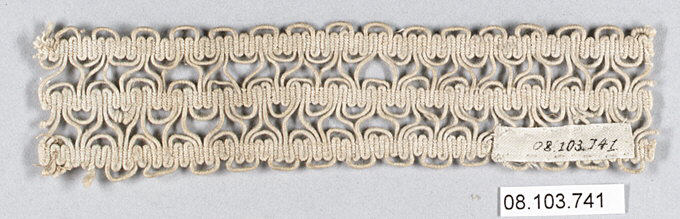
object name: gimp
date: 1801-1900